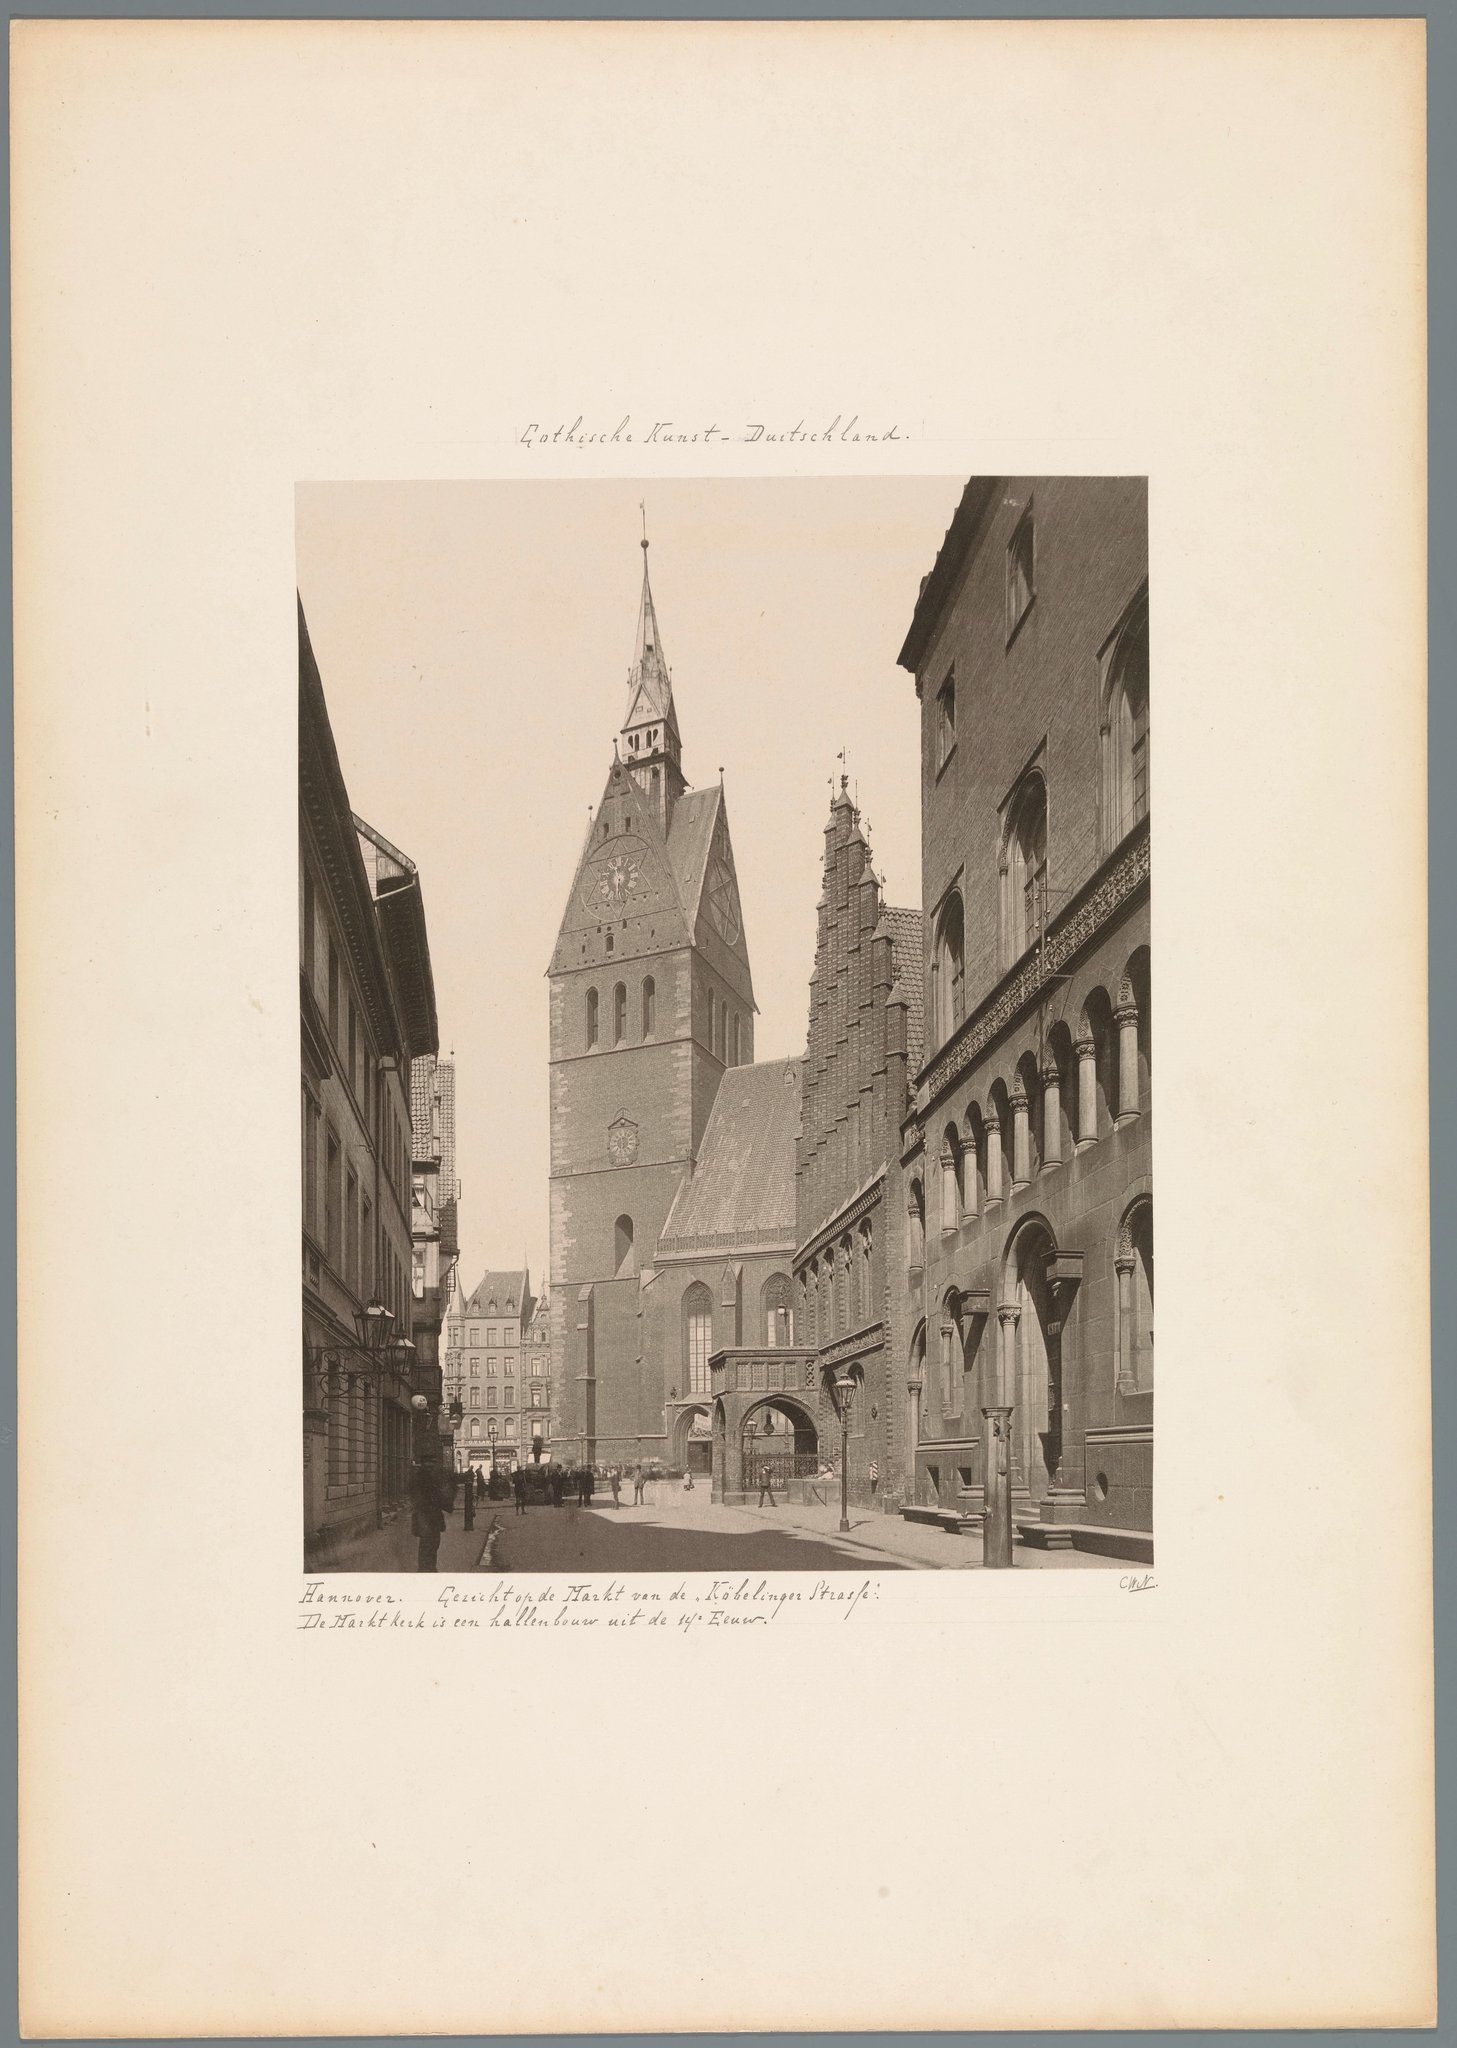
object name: photograph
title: Gezicht op de Marktkerk te Hannover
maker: Anonymous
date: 1875-1900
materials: cardboard, paper, ink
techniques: photograph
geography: hannover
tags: tower, clock tower ~ monumental adornment, church (exterior), street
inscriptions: collector's mark: ‘KUNSTNIJVERHEIDSCHOOL QUELLINUS AMSTERDAM FRANS HALSSTRAAT 14.’, inscription: ‘CWN.’, inscription: ‘Gothische Kunst - Duitschland.’, collector's mark: ‘INSTITUUT VOOR KUNST-NIJVERHEIDSONDERWIJS GABRIËL METSUSTRAAT No. 16 AMSTERDAM’